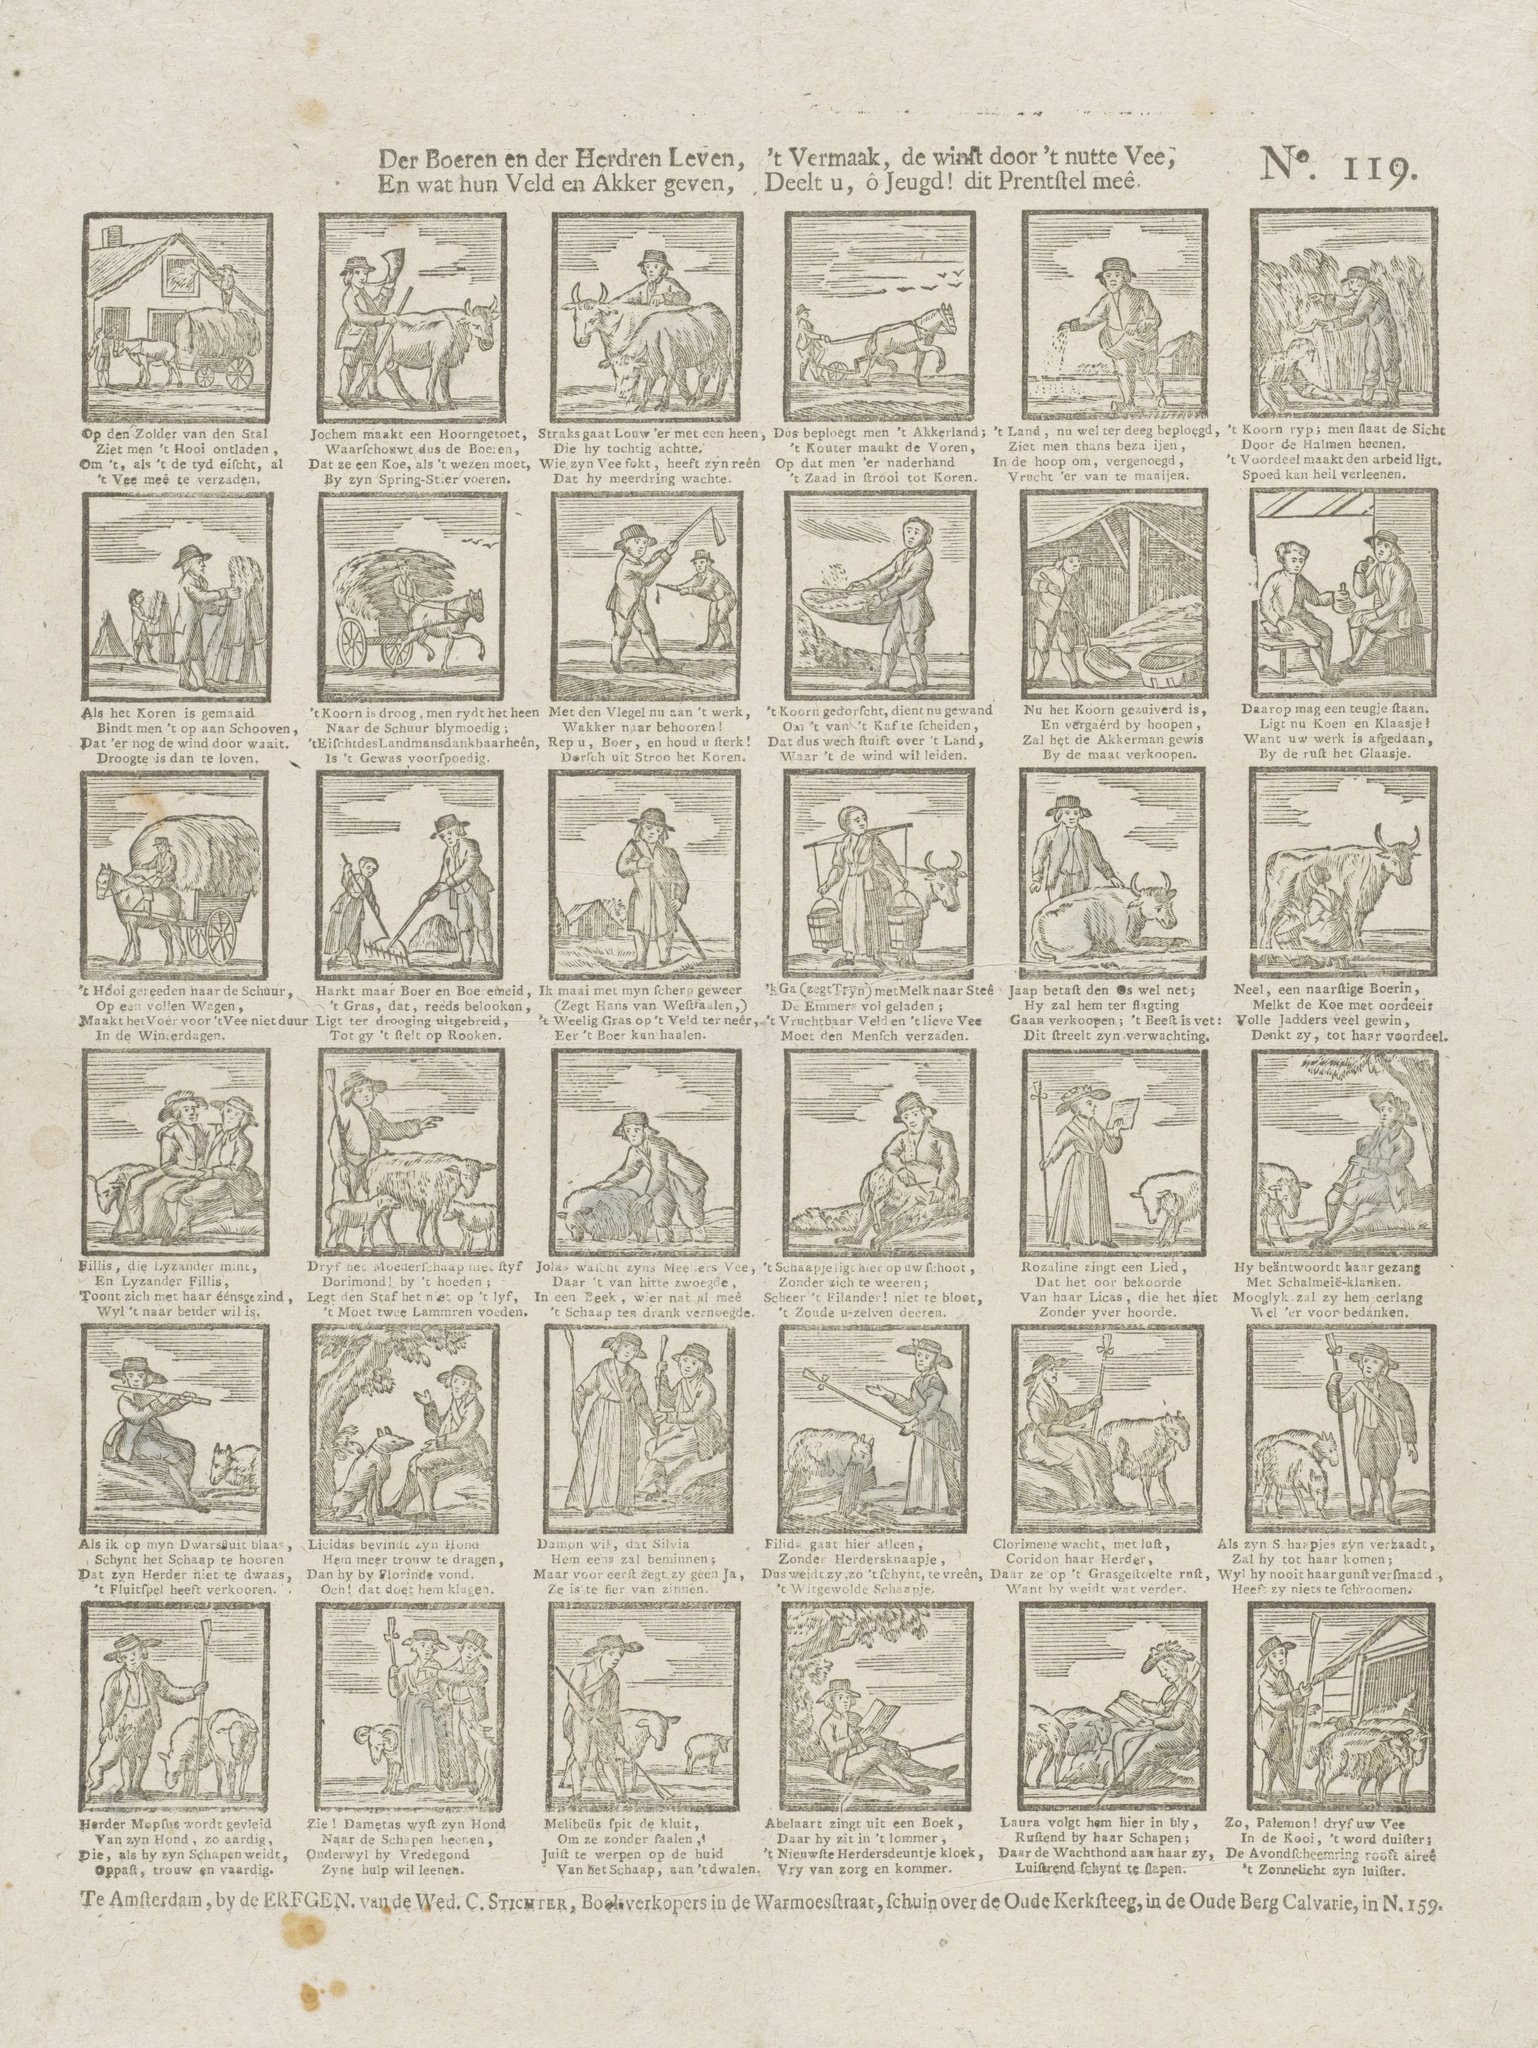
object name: popular print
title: Der boeren en der herdren leven, / En wat hun veld en akker geven, / 't vermaak, de winst door 't nutte vee, / Deelt u, ô jeugd! dit prentstel meê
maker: Anonymous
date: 1715-1813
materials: paper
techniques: colour, letterpress printing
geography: netherlands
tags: herding, herdsman, herdswoman, shepherd, shepherdess, cowherd, etc., farmers, agriculture, cattle-breeding, horticulture, flowerculture, etc.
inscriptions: collector's mark: Lugt 2760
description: Blad met 36 voorstellingen uit het leven en werk van de boer en de herder. Onder elke afbeelding een vierregelig vers. Genummerd: No. 119.